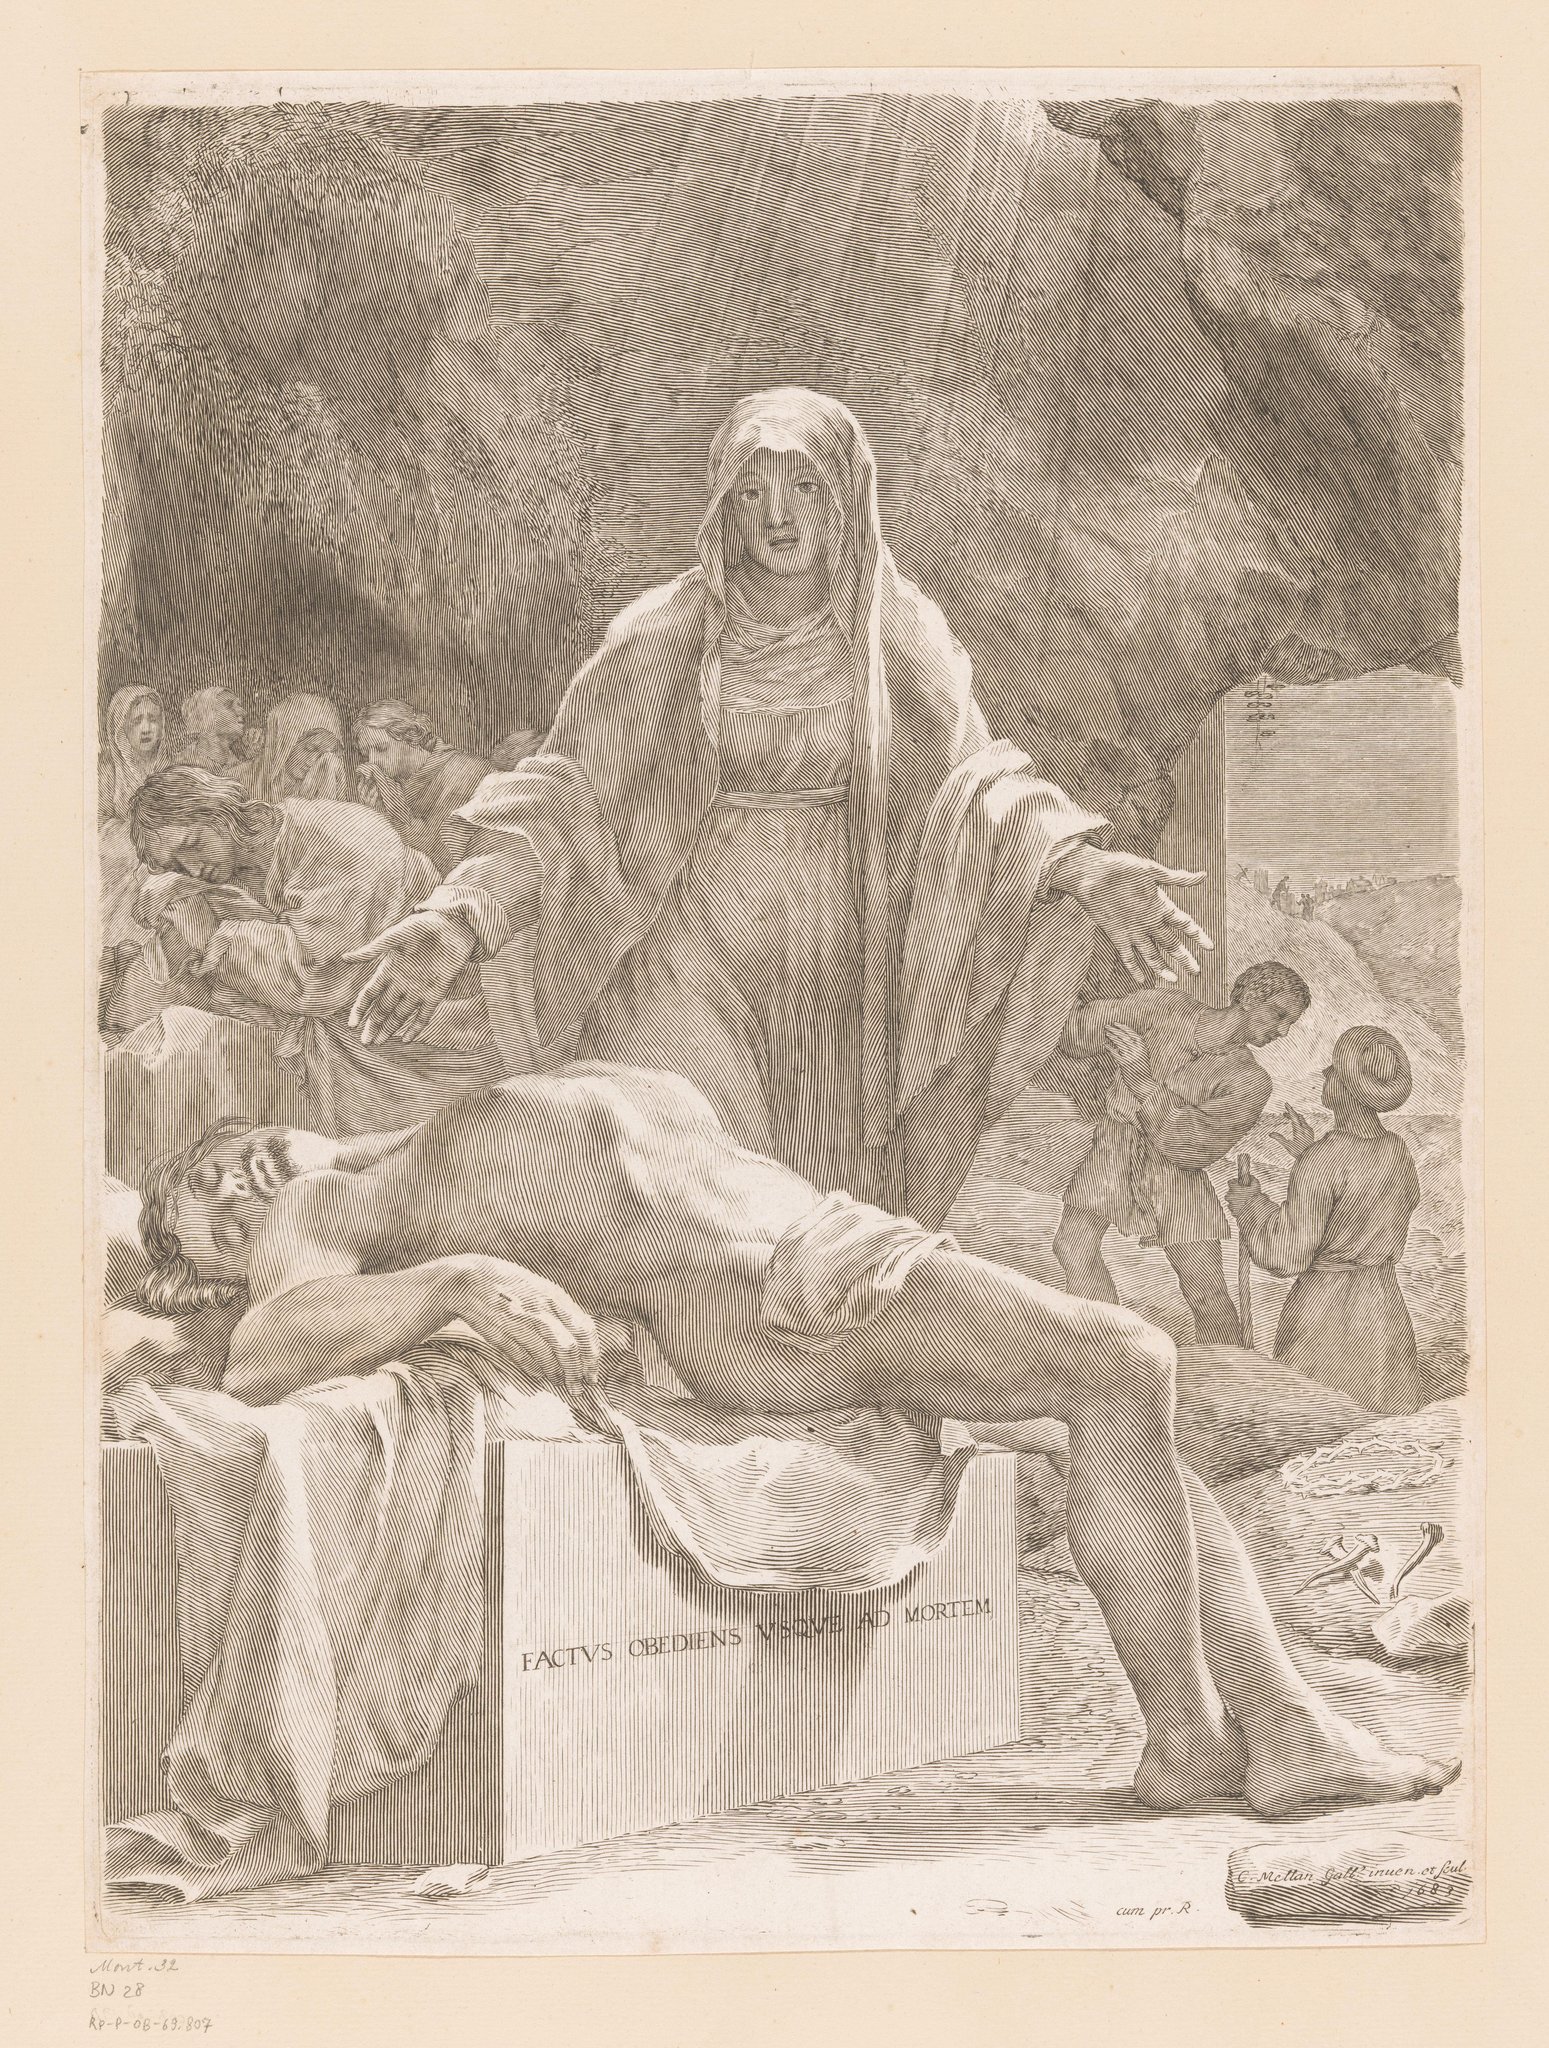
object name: print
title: Bewening van Christus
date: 1683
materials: paper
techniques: engraving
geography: france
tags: lamentation over the dead christ by his relatives and friends (christ usually without crown of thorns)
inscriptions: collector's mark: Lugt 240